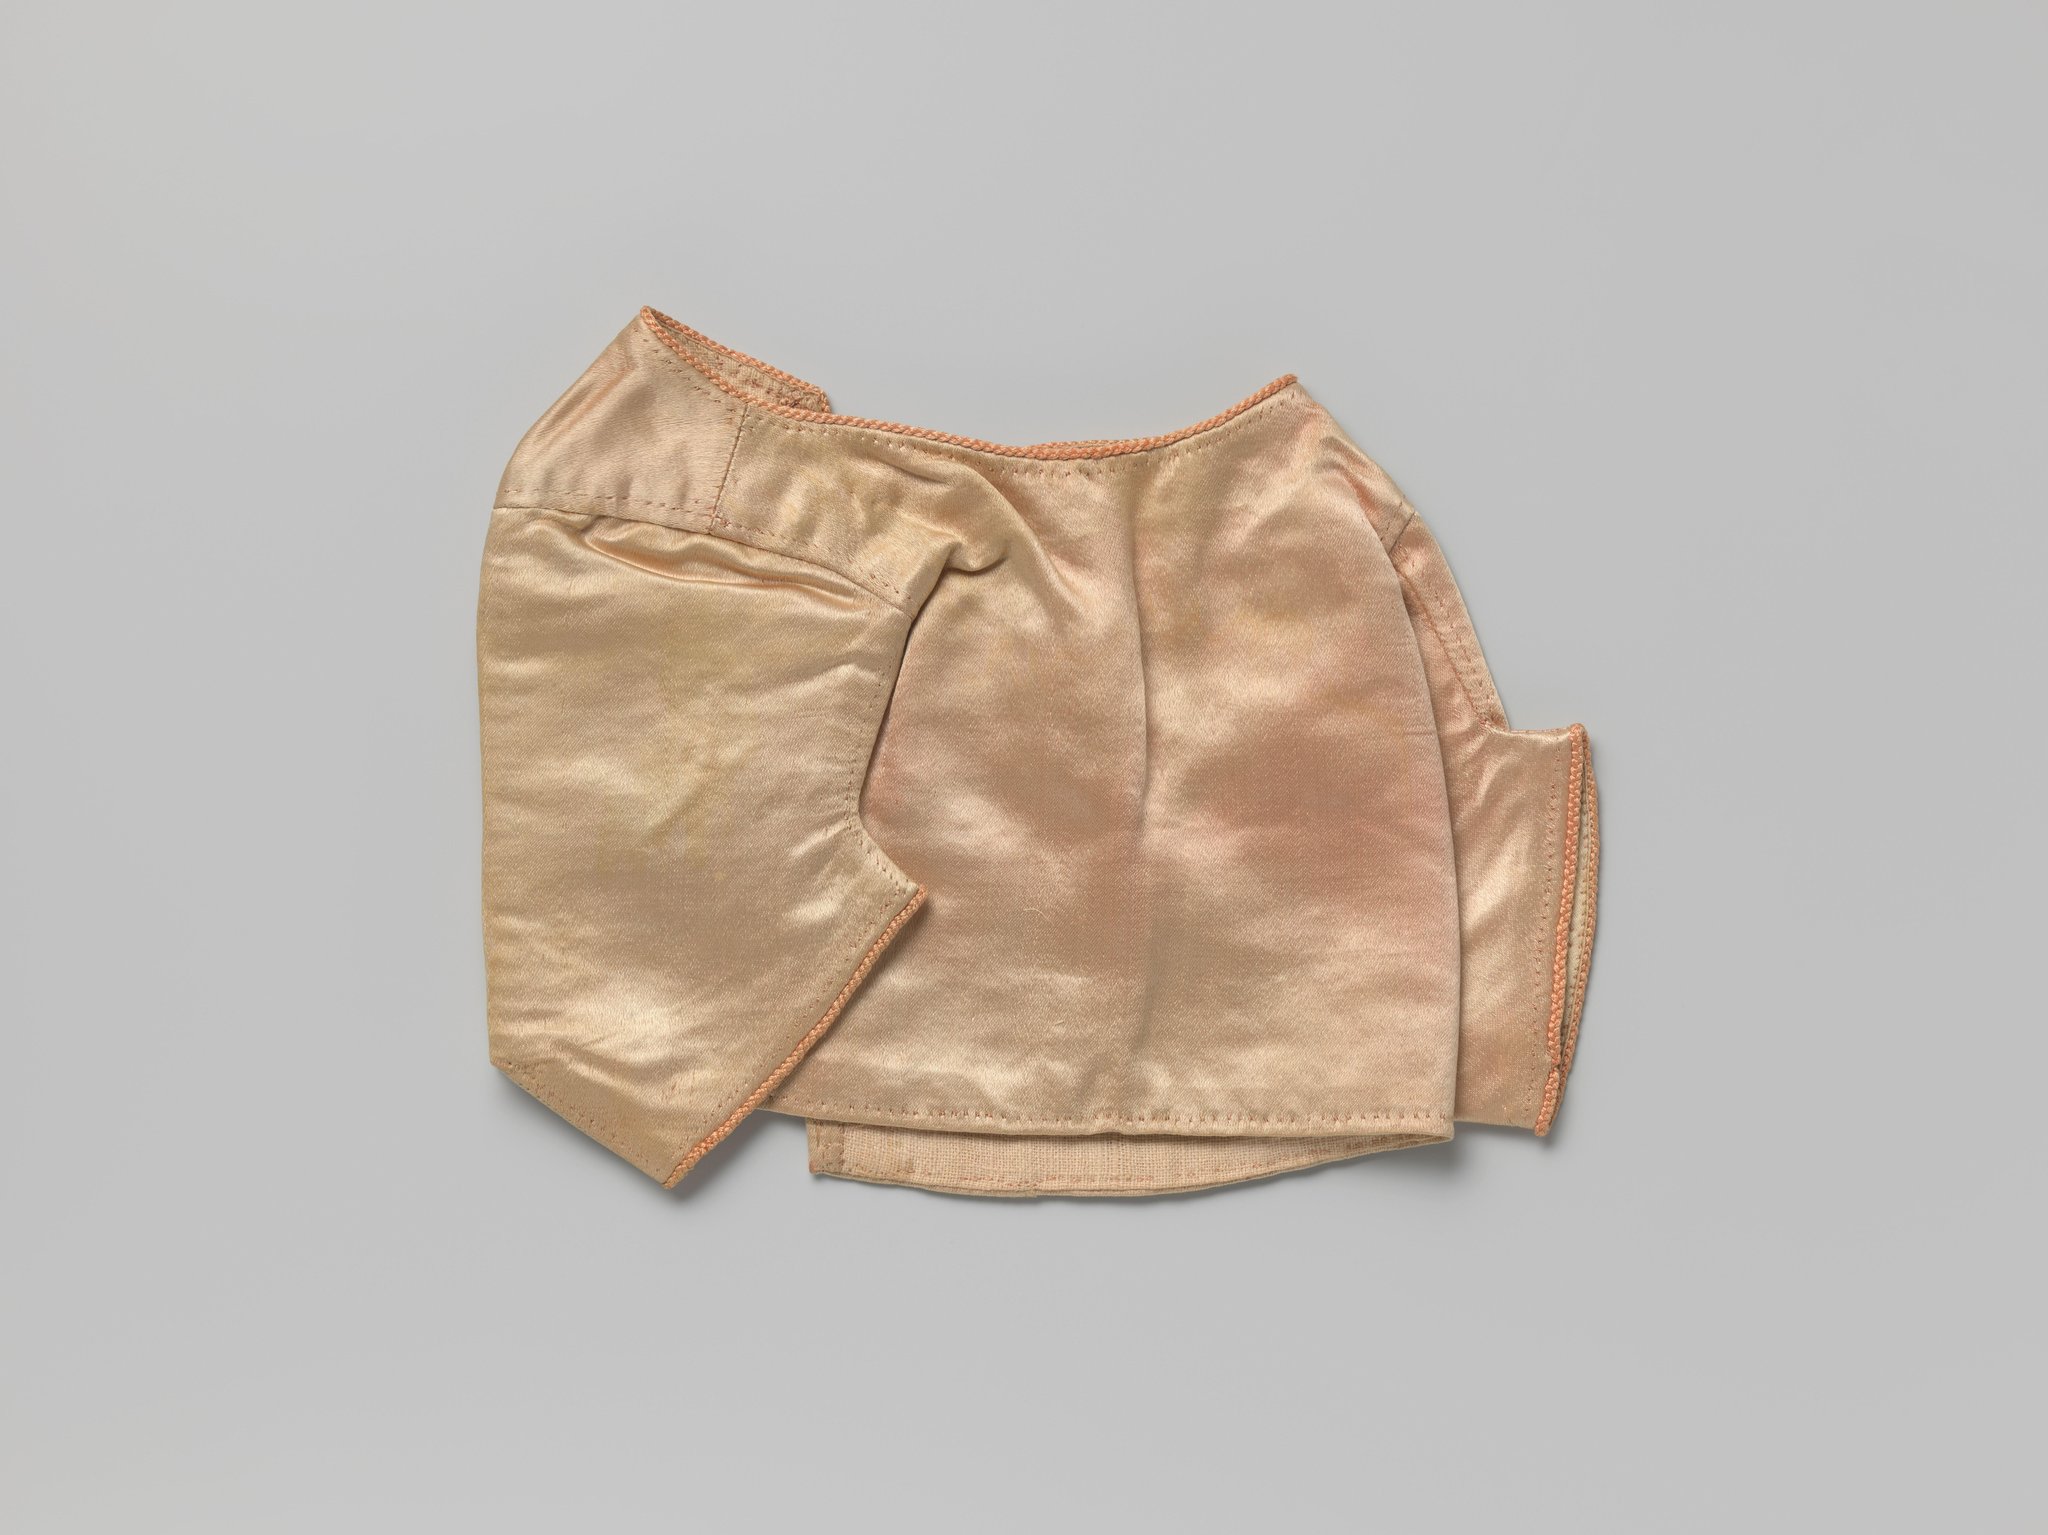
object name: kinderlijf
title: Kinderlijf van zalmkleurige zijden damast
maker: Anonymous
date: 1730-1740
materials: silk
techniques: damask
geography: france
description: Kinderlijf van zalmkleurige zijden damast. Patroon van verticaal slingerende gevarieerde banden met rastervulling, oversneden door grote bladeren en bloemen aan tak. Model met splitspuntje, voor en achter, in de taille. Vierkante hals. Wijde elleboogmouw met geplooide manchet, die in de binnenholte zeer smal en aan buitenhoek zeer breed en in een hoek gelegd is. Achtersluiting met vier zijden lamfittenbanden, ceriserode bloemrank op witte fond. Met de hand genaaid. Voering van cerise camelot; in de mouwen van blauw linnen. Aan de voorzijde verschoten.